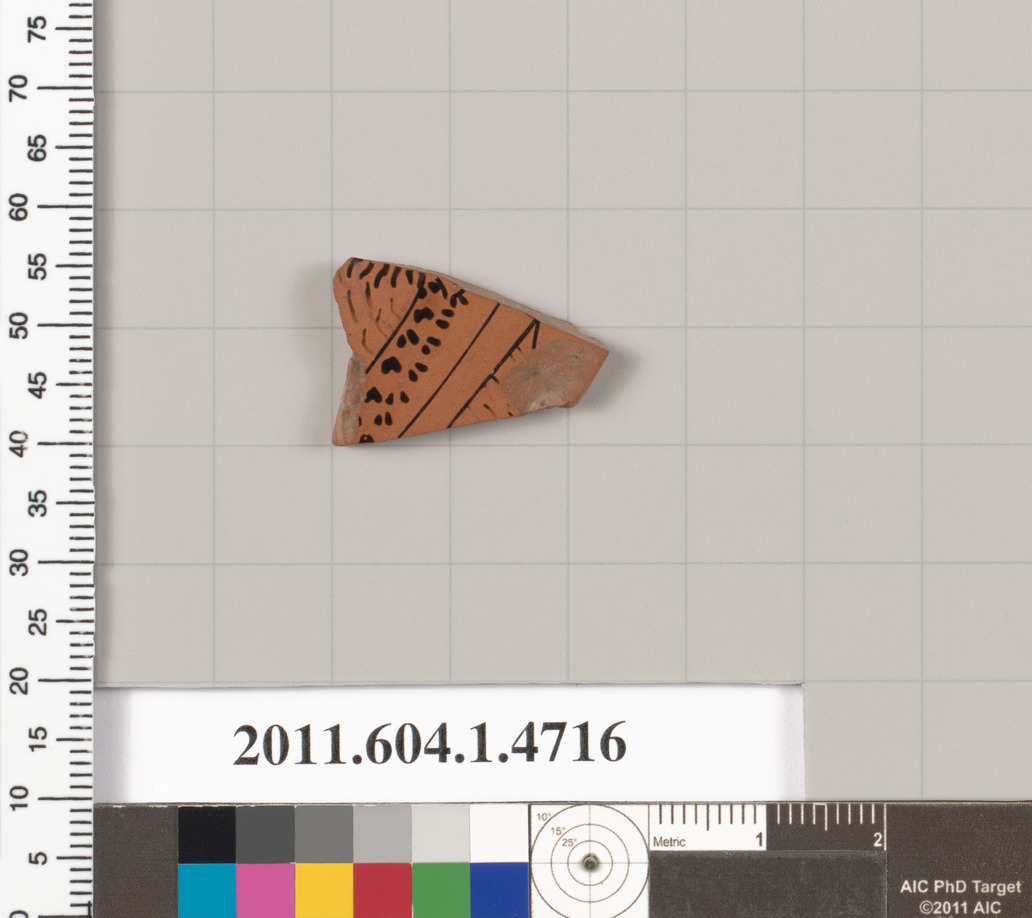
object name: kylix fragment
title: Terracotta fragment of a kylix (drinking cup)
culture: greek, attic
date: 490-480 BCE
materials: terracotta